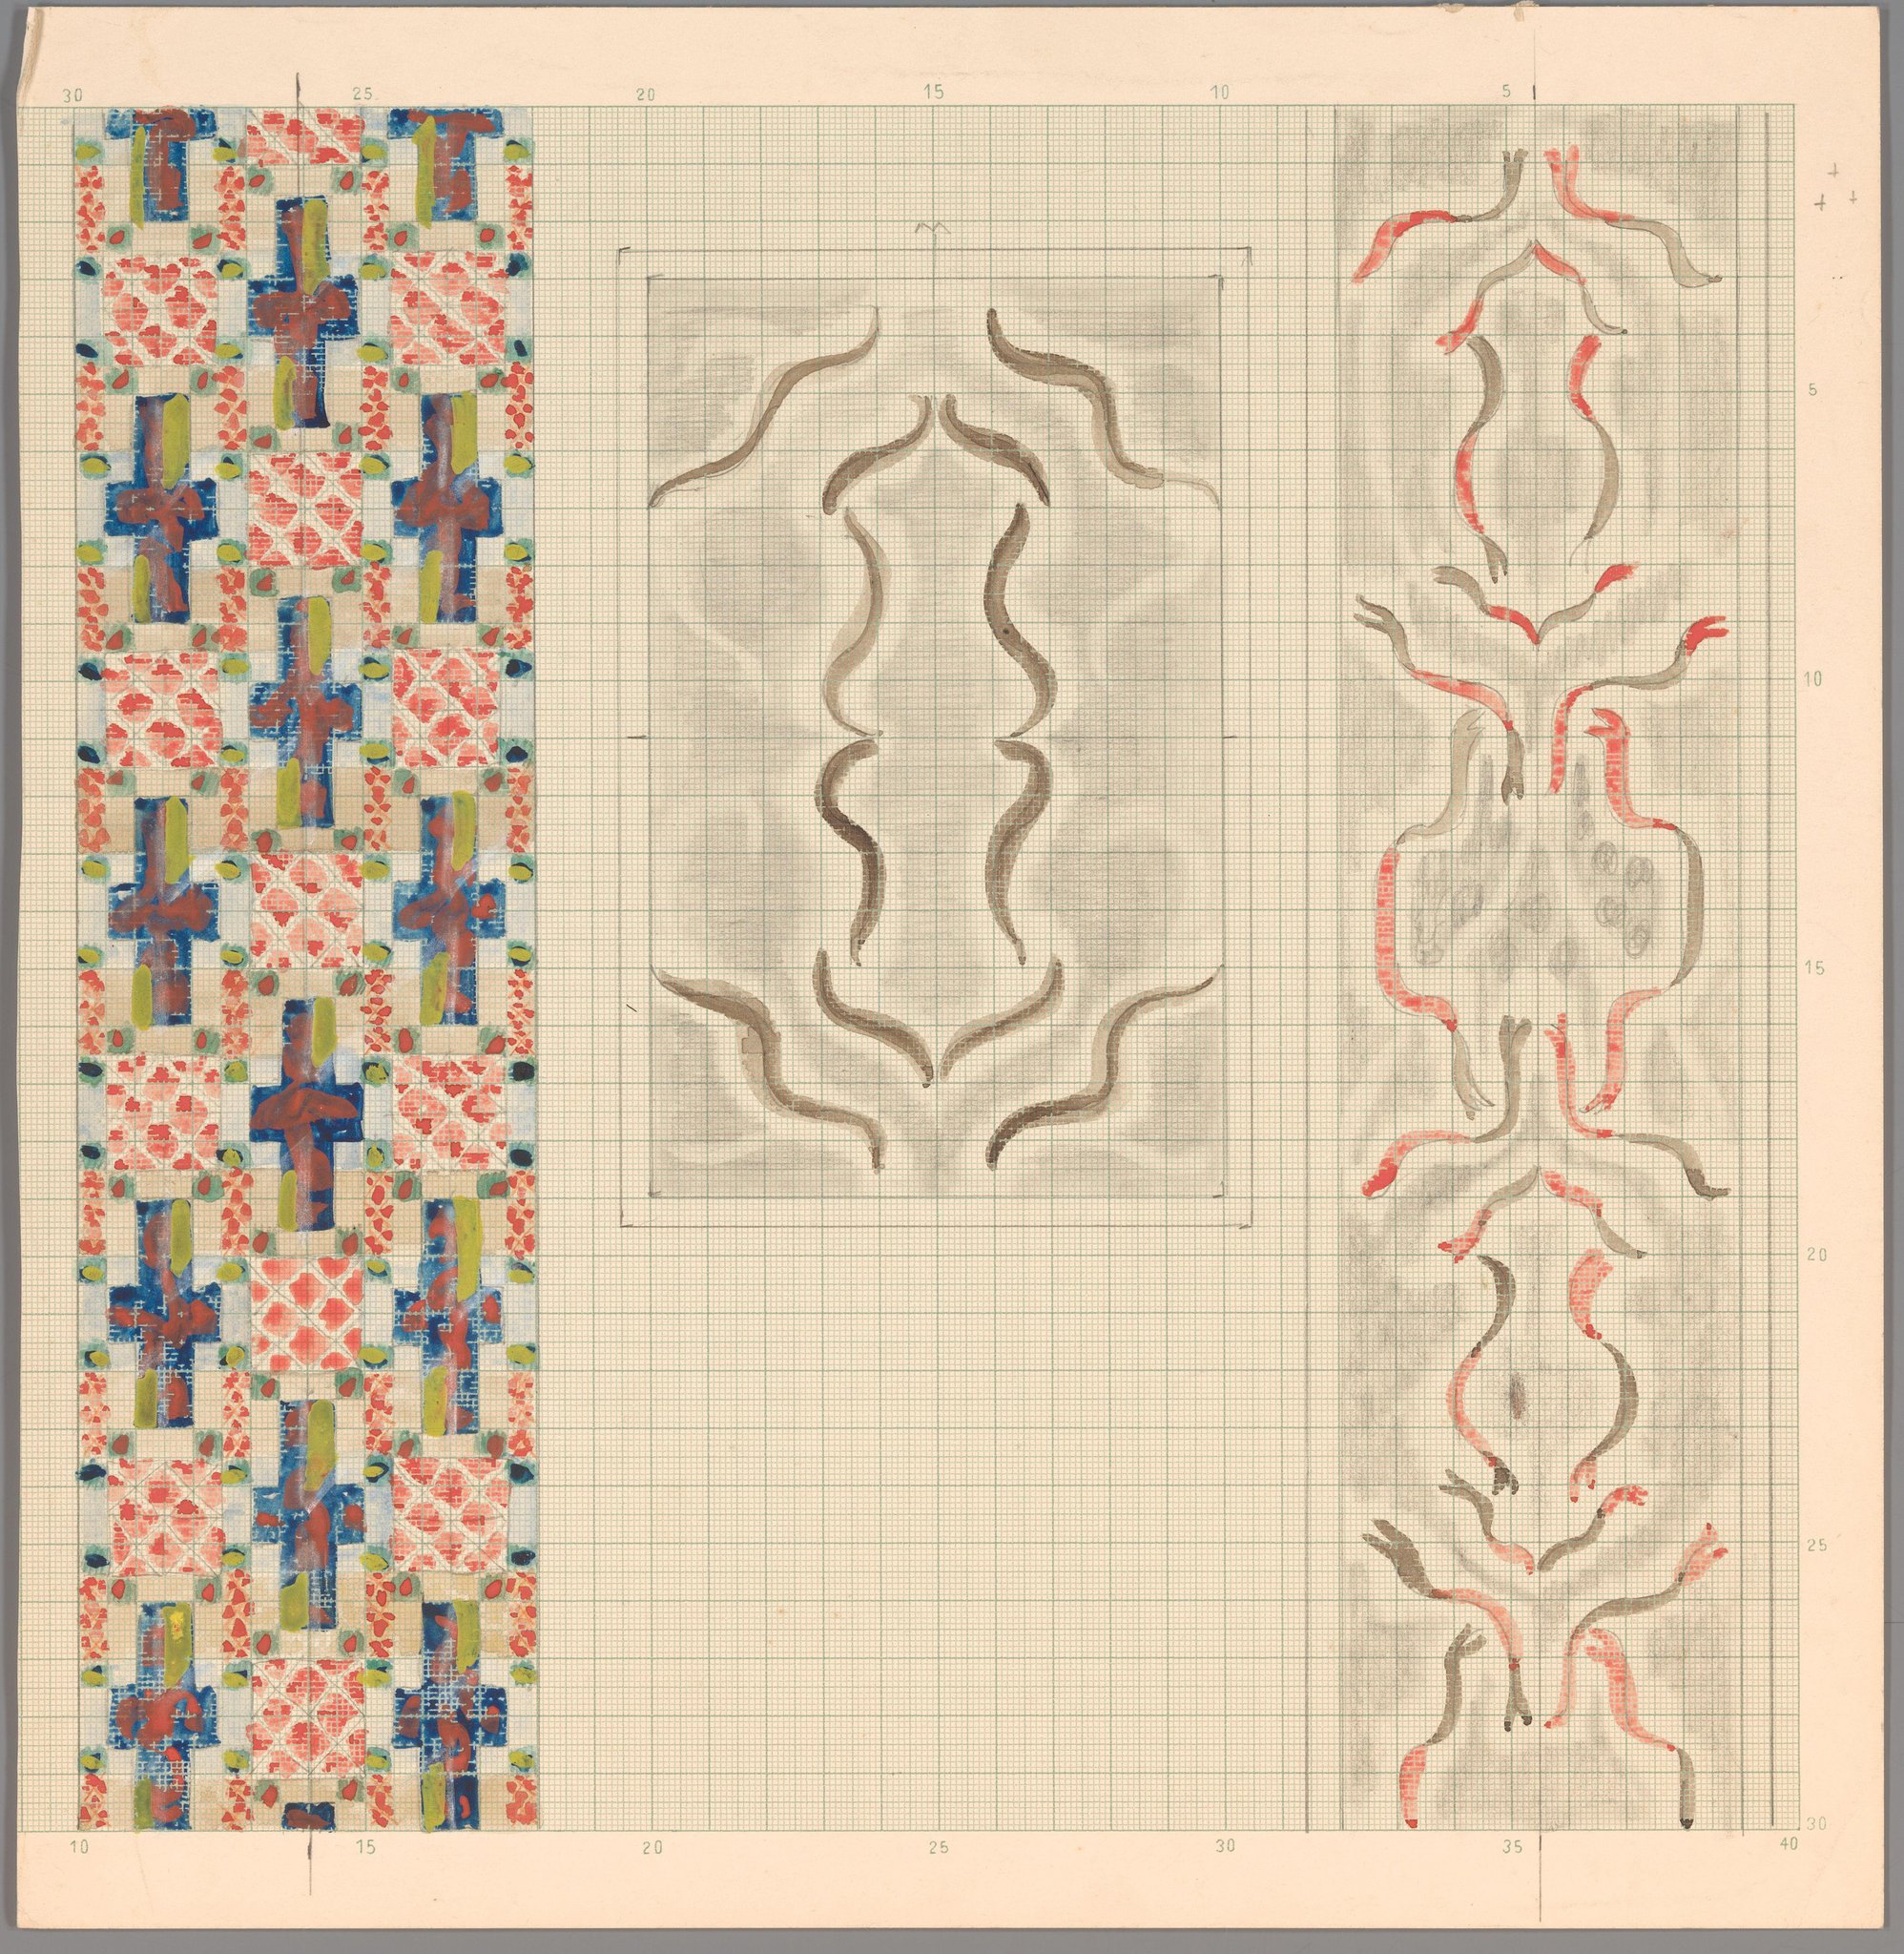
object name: drawing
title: Drie decoratieve ontwerpen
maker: carel adolph lion cachet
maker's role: draughtsman, print maker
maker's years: 1864-1945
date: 1874-1945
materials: pencil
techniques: brush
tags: ornaments ~ art, carpet, rug